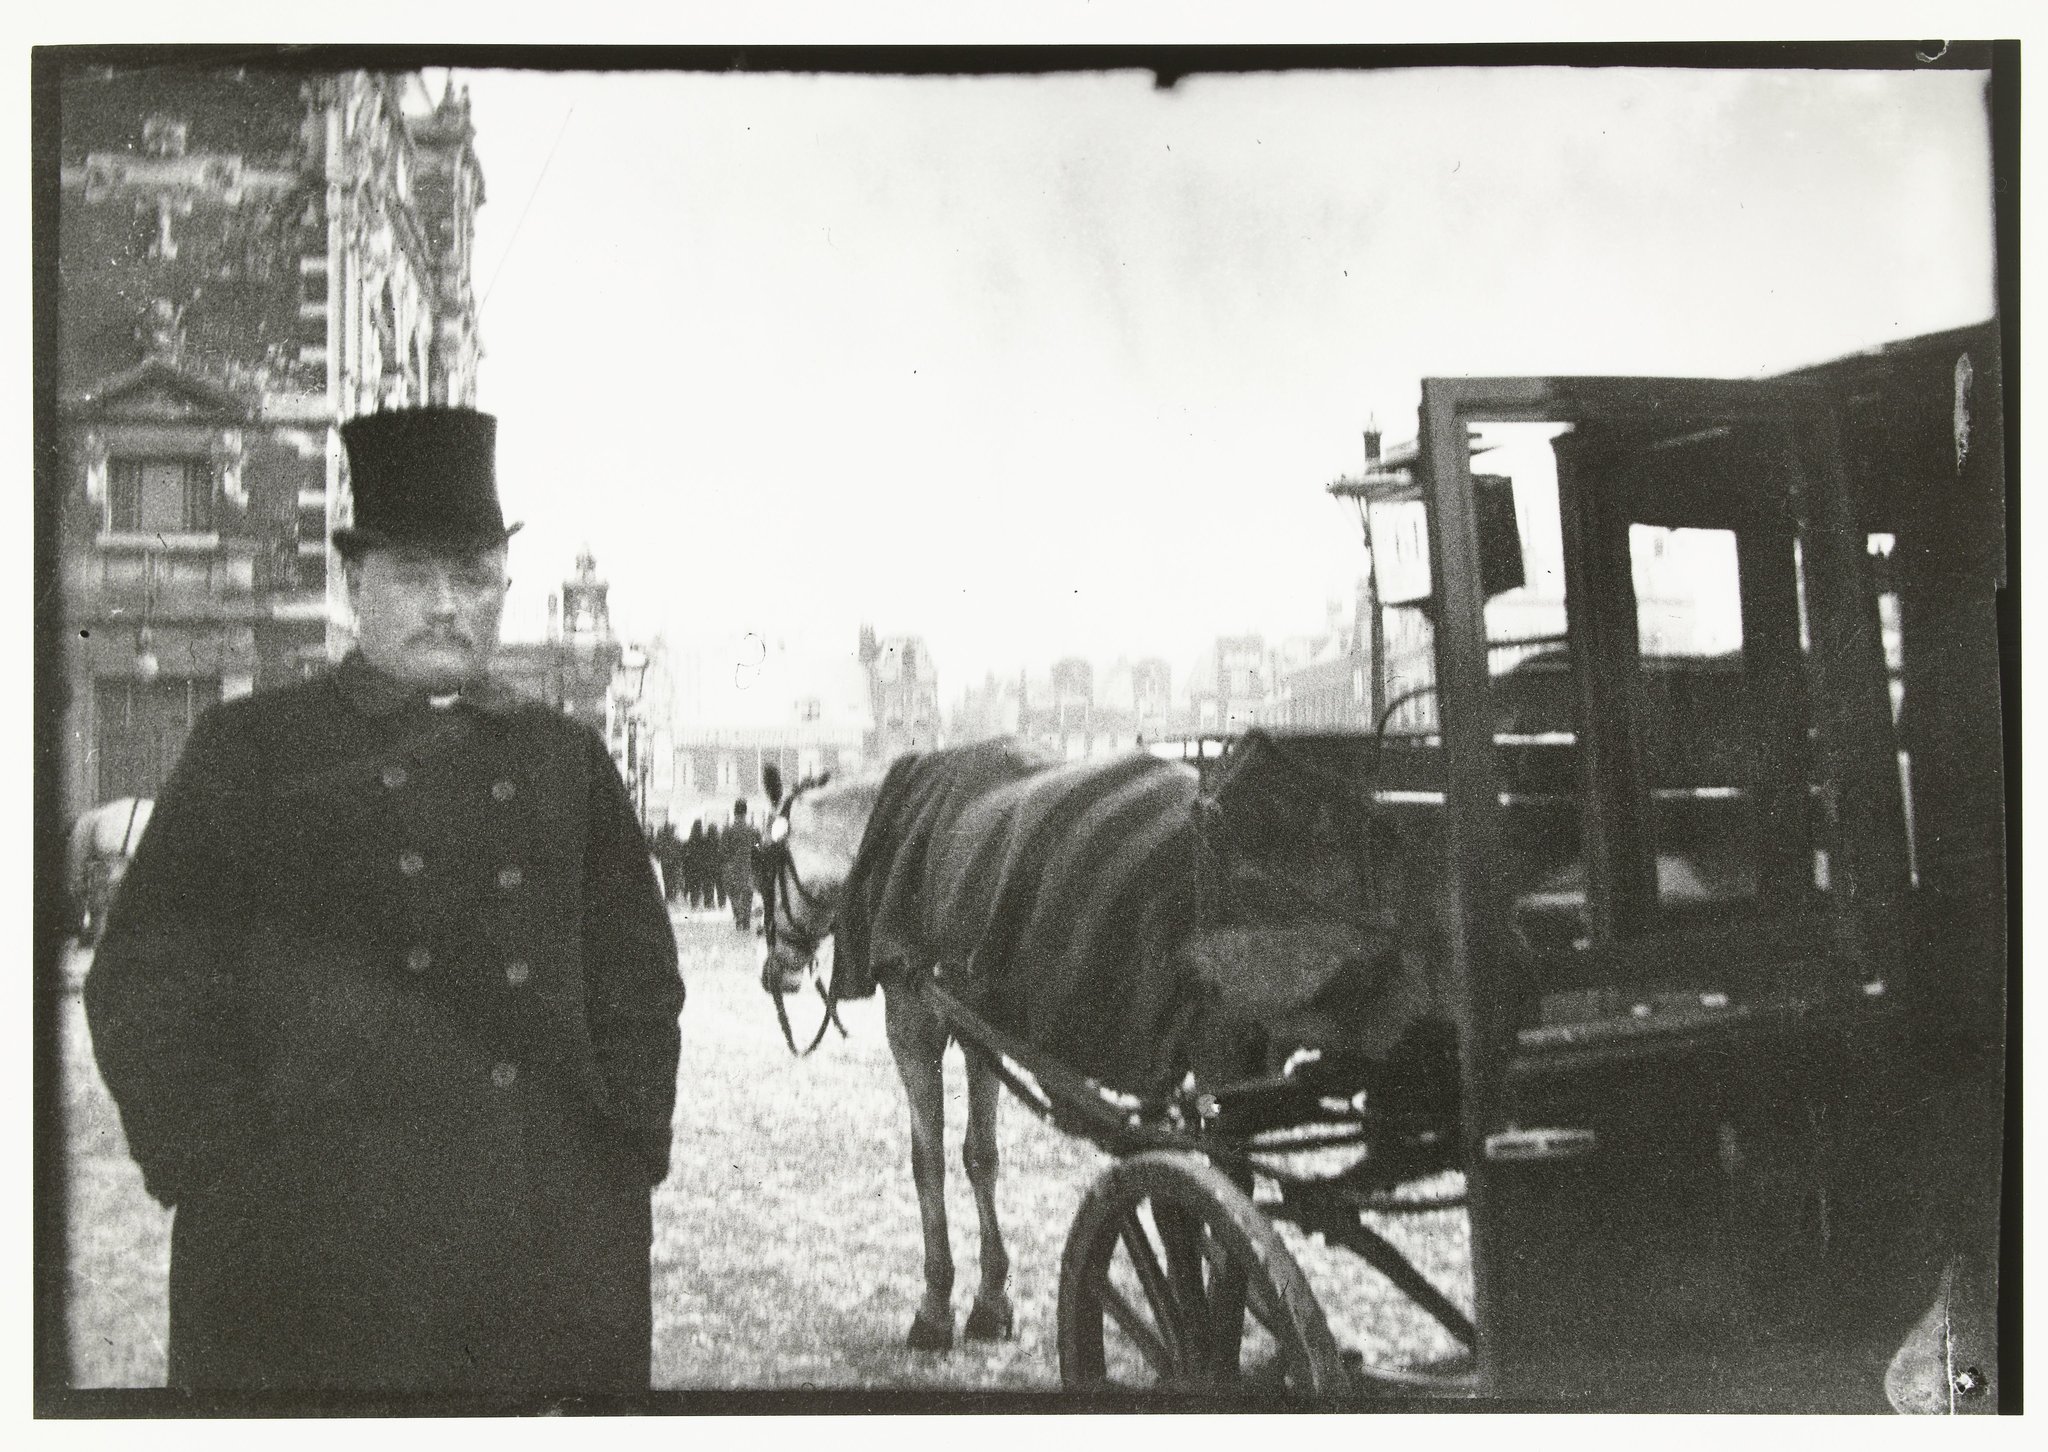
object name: photograph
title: Paarden met rijtuig op het Leidseplein in Amsterdam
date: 1890-1910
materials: paper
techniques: gelatin silver print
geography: netherlands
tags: leidseplein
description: Moderne afdruk van negatief BR 997 (collectie RKD).